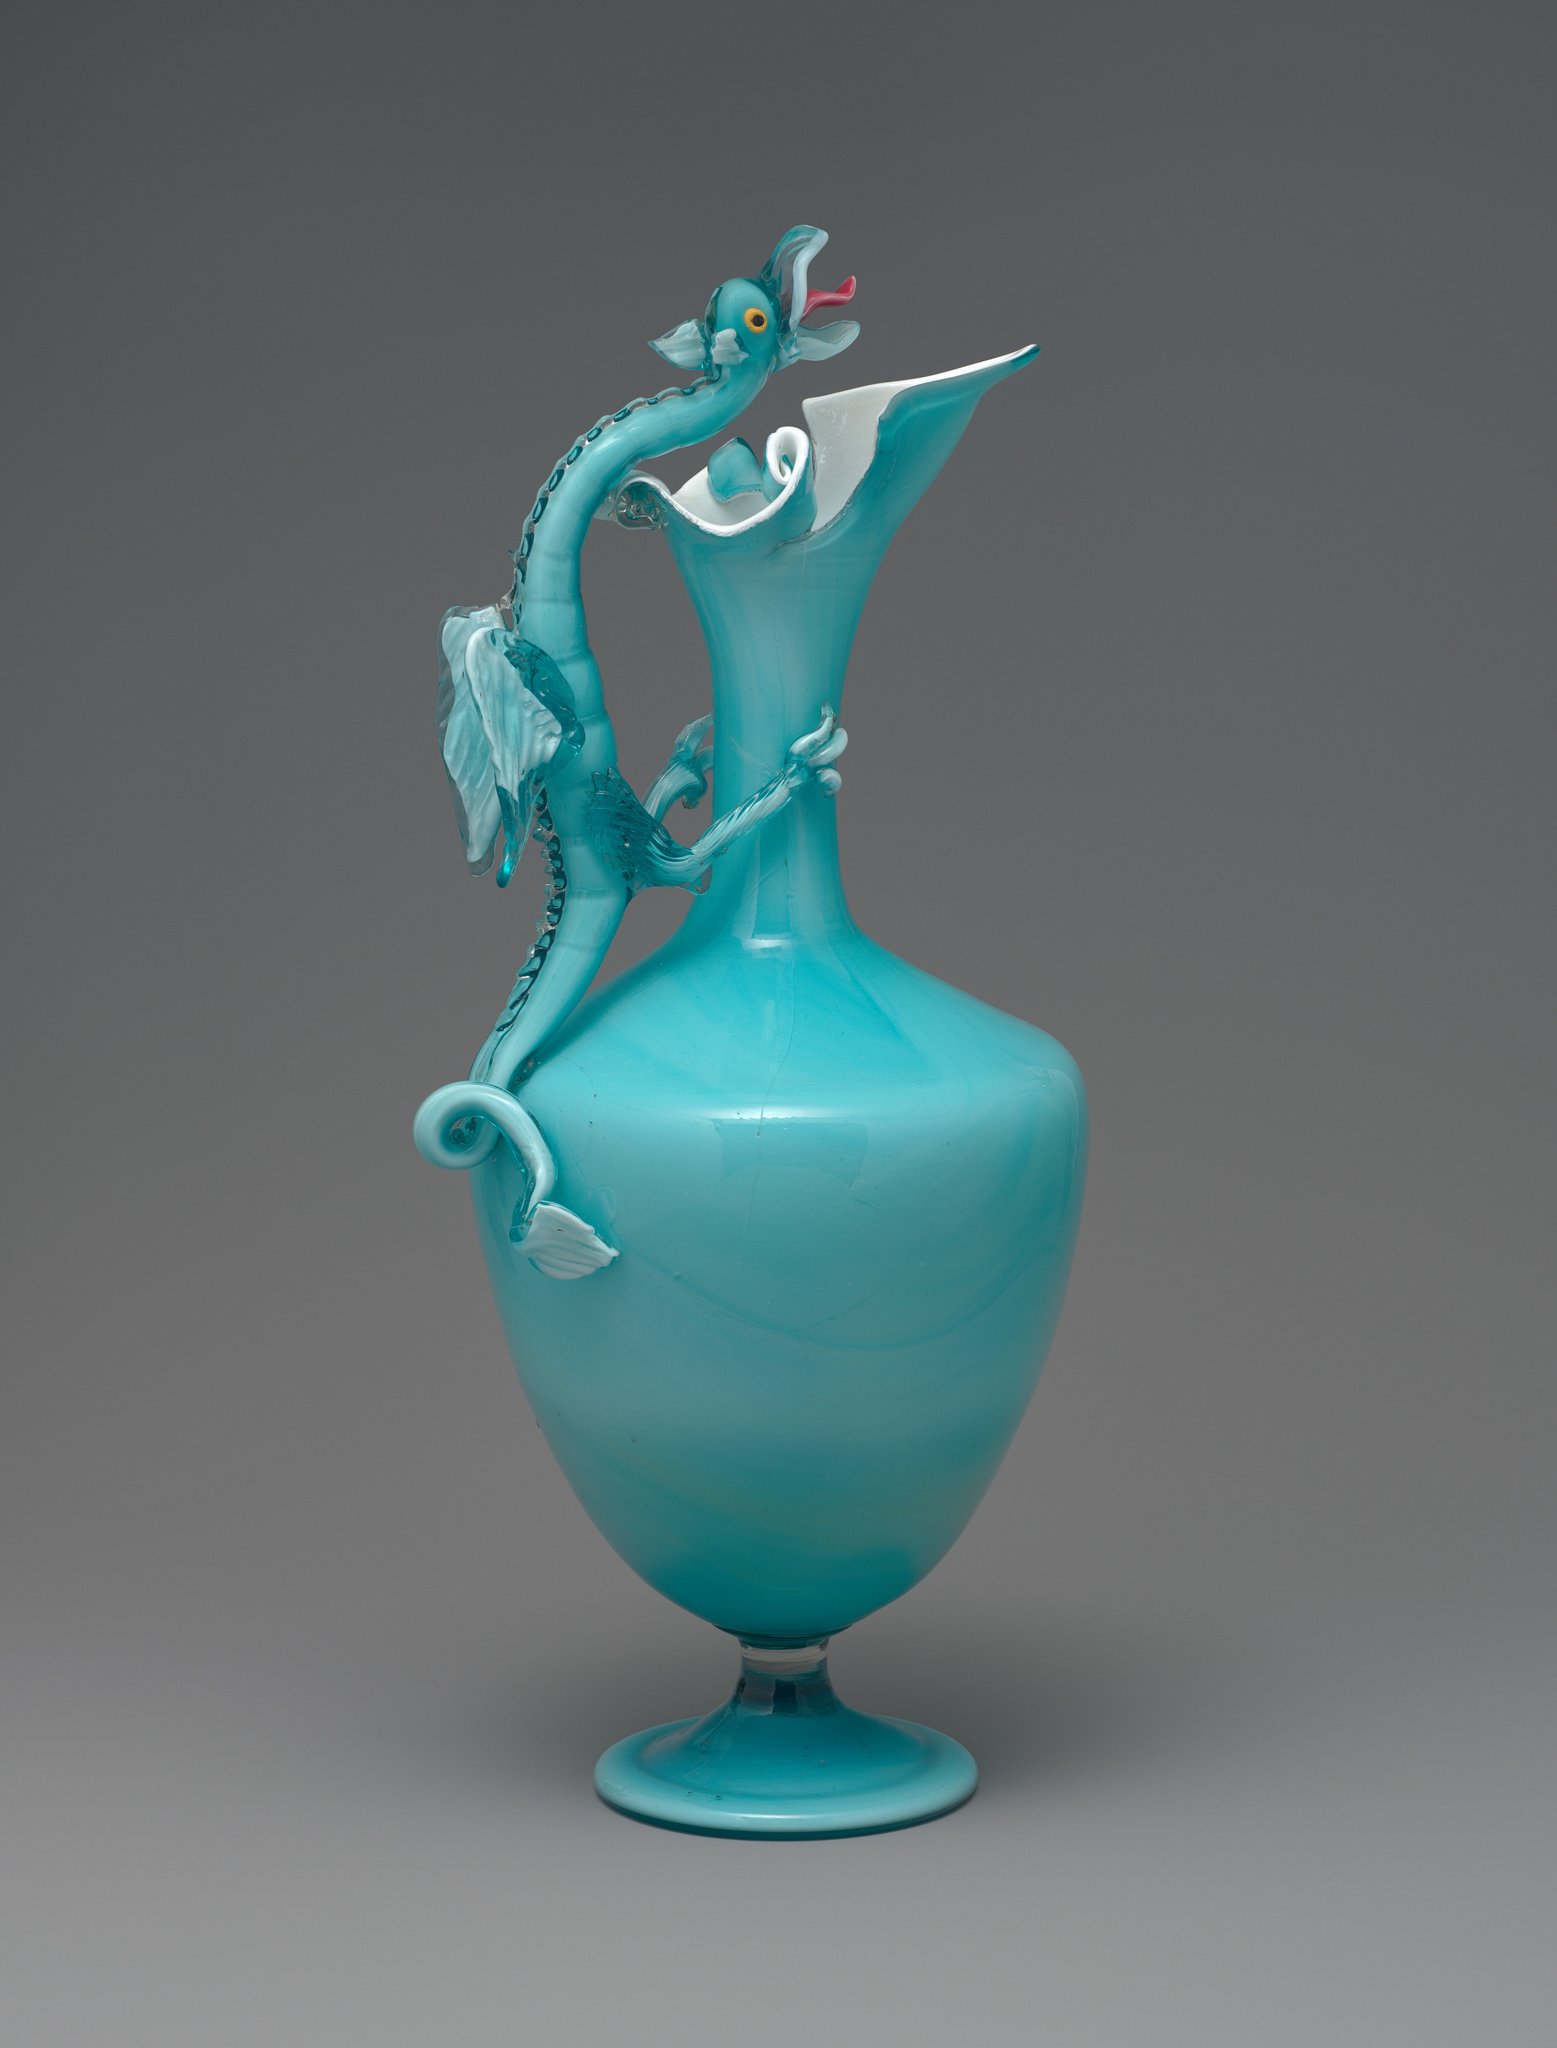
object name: ewer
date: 1801-1900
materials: glass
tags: dragons